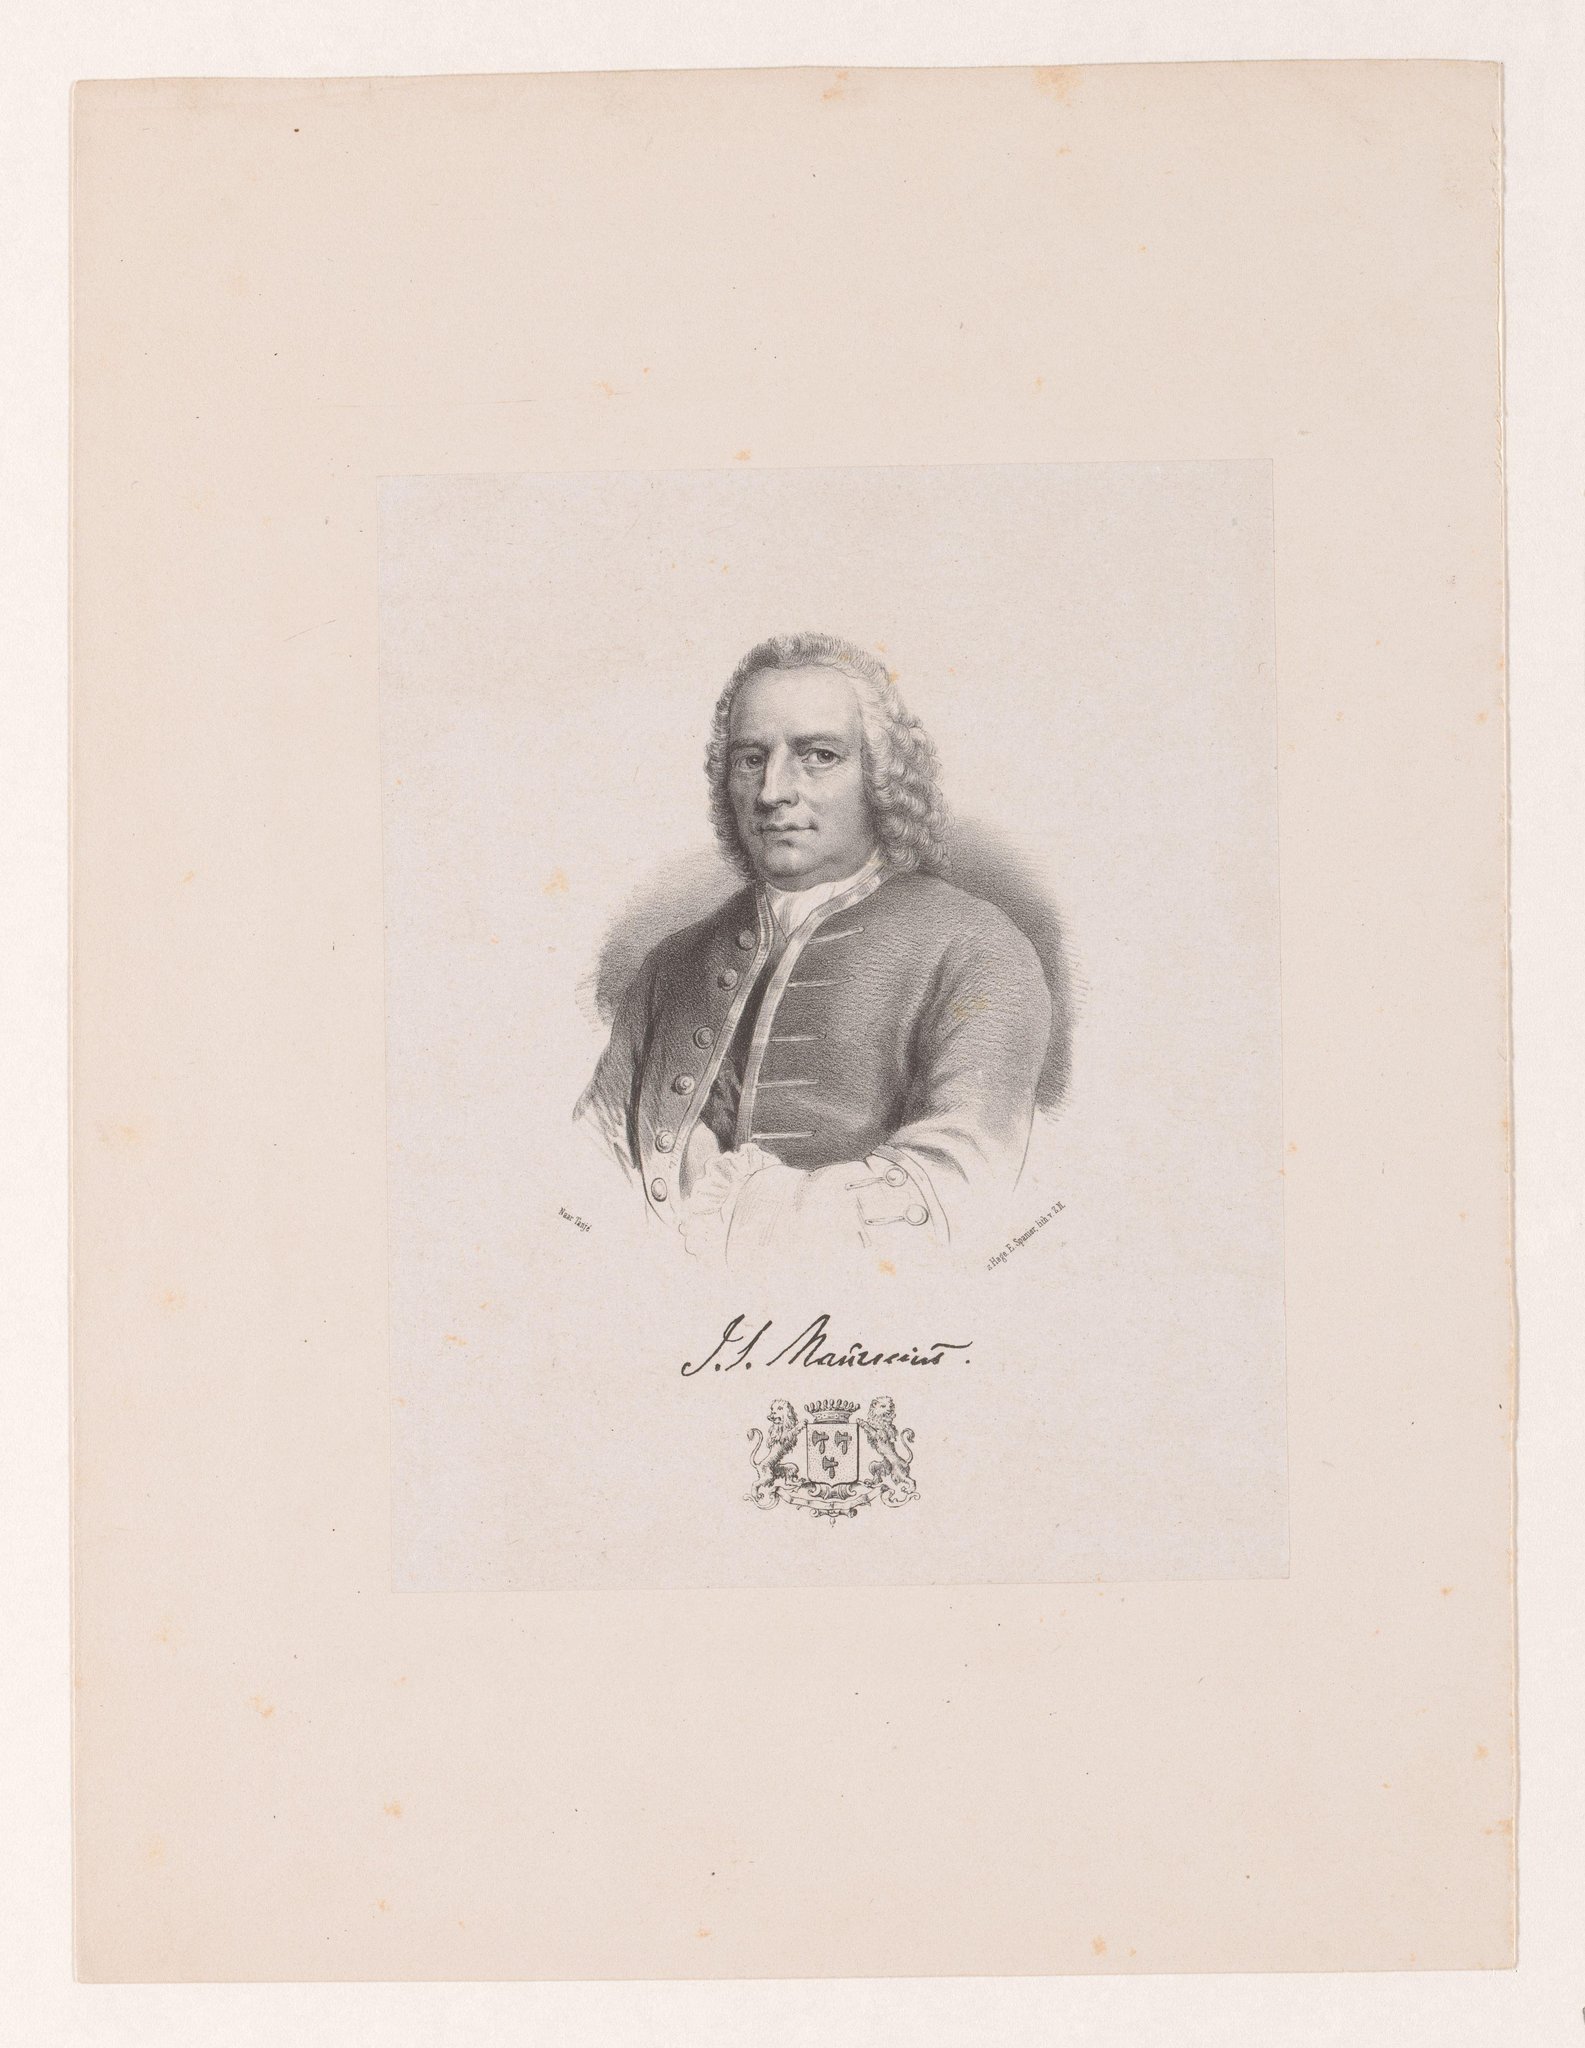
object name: print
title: Portret van Joan Jacob Mauricius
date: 1831-1863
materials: paper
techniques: lithograph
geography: the hague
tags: amsterdam, joan jacob mauricius, historical persons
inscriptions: collector's mark: Lugt 2228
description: Onder het portret de signatuur van de geportretteerde.